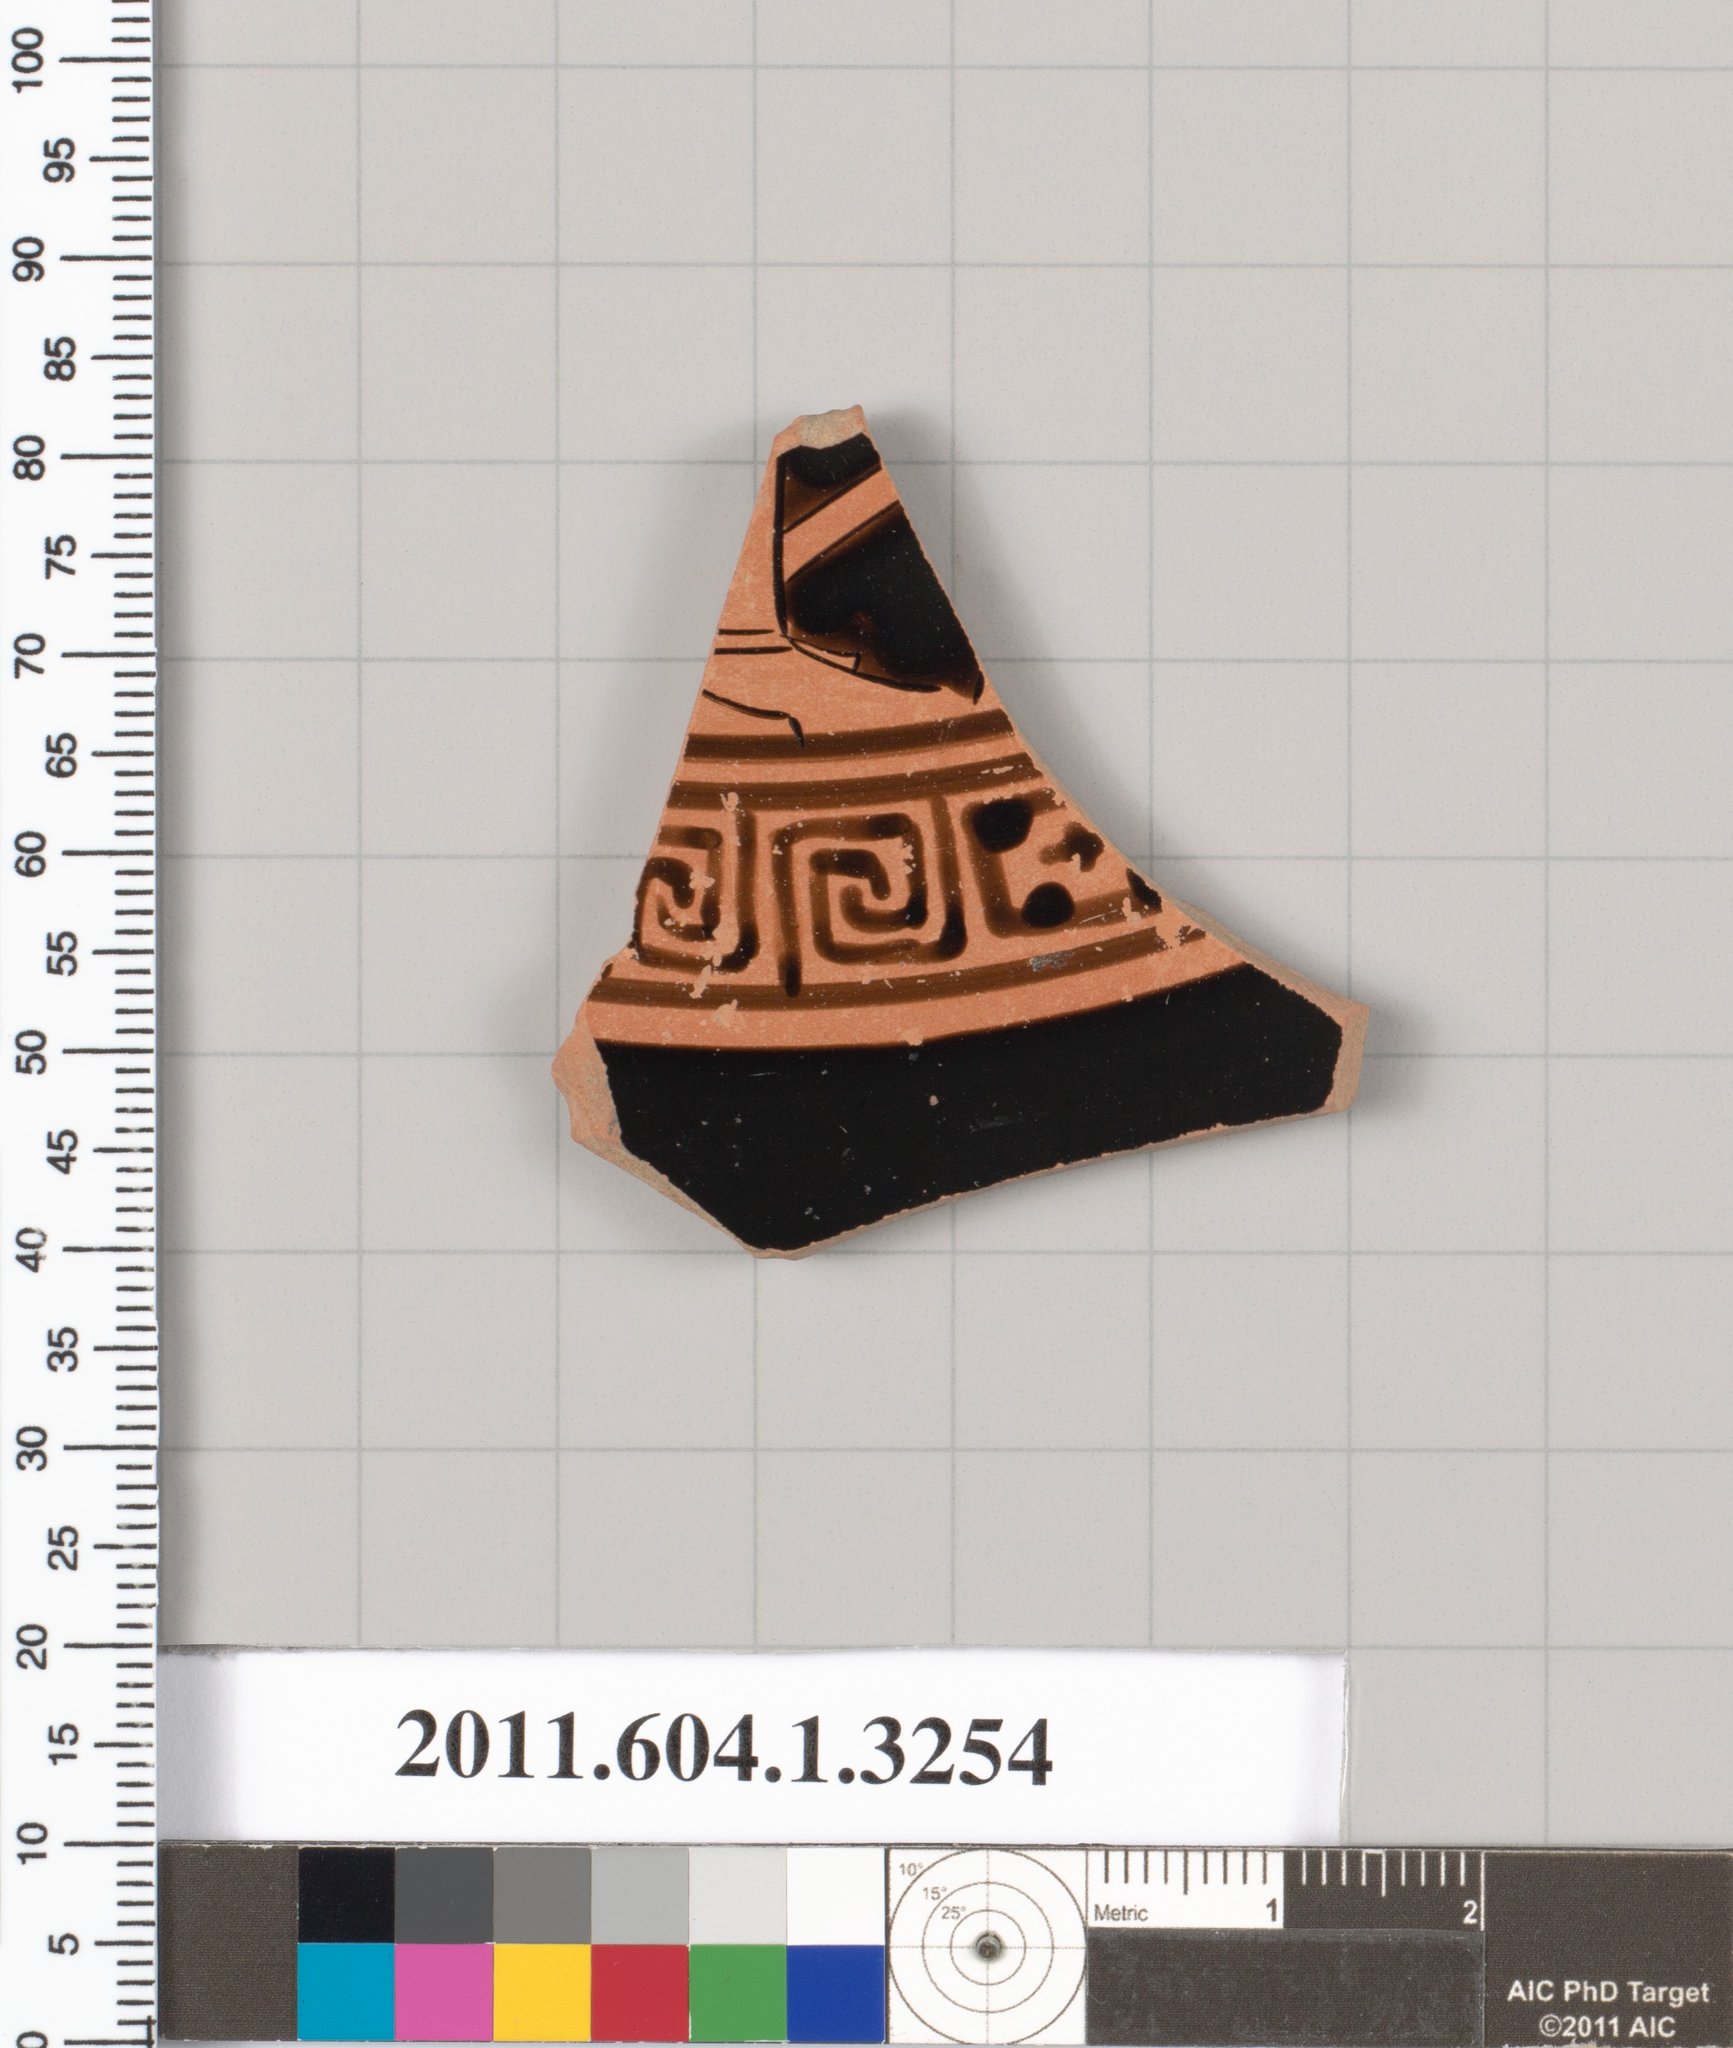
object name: kylix fragment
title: Terracotta fragment of a kylix (drinking cup)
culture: greek, attic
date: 490-480 BCE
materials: terracotta